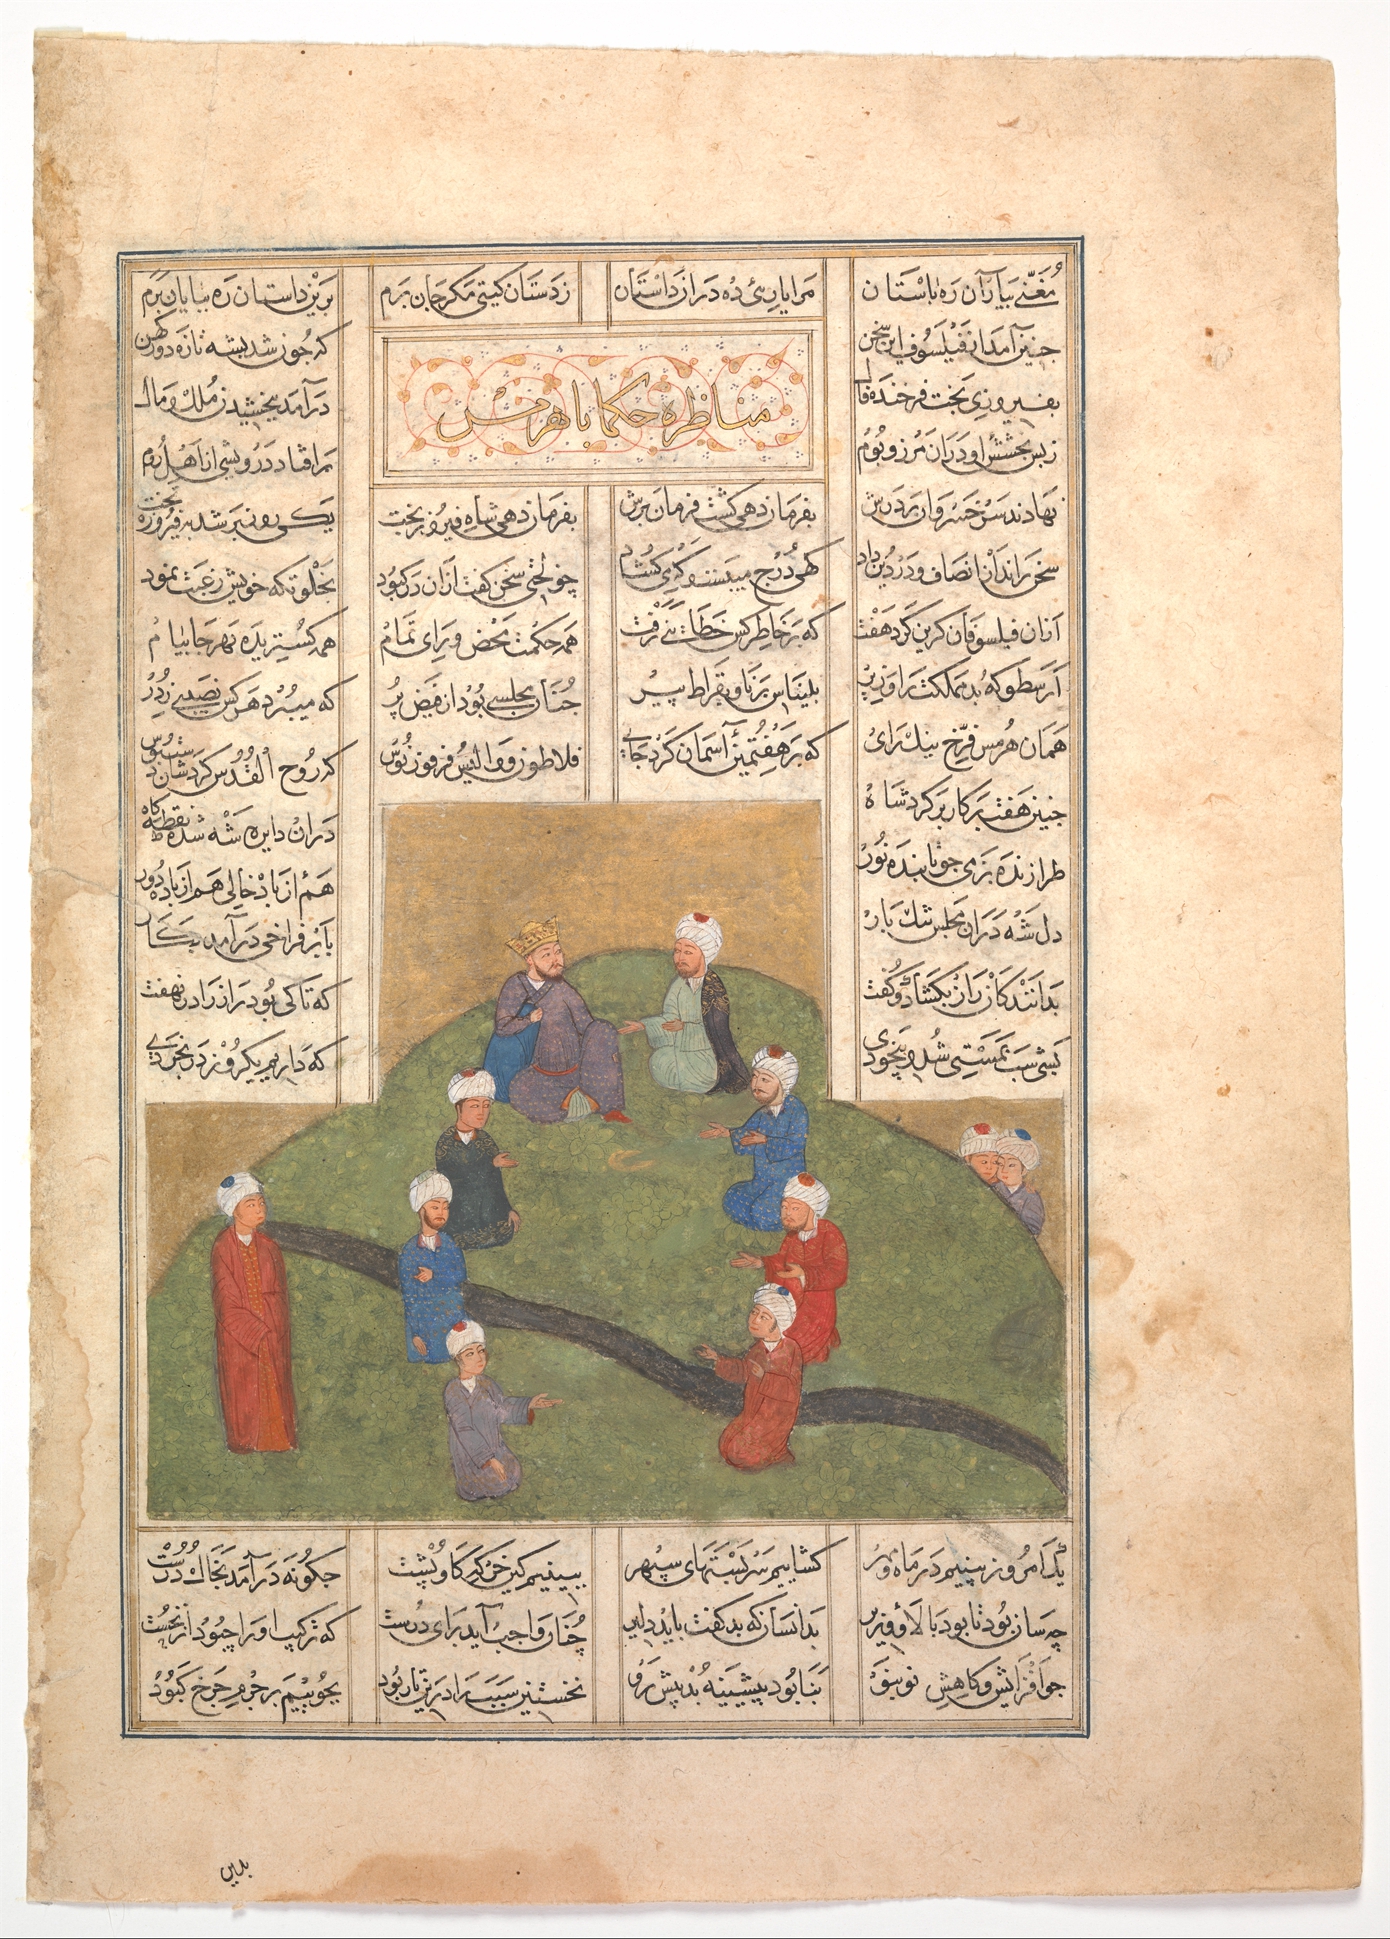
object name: folio from an illustrated manuscript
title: "Alexander and the Circle of Seven Sages", Folio from a Khamsa (Quintet) of Nizami of Ganja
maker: nizami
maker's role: author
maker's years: 1141-1209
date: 1401-1500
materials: gold, ink, paper, watercolor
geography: iran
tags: alexander the great,men